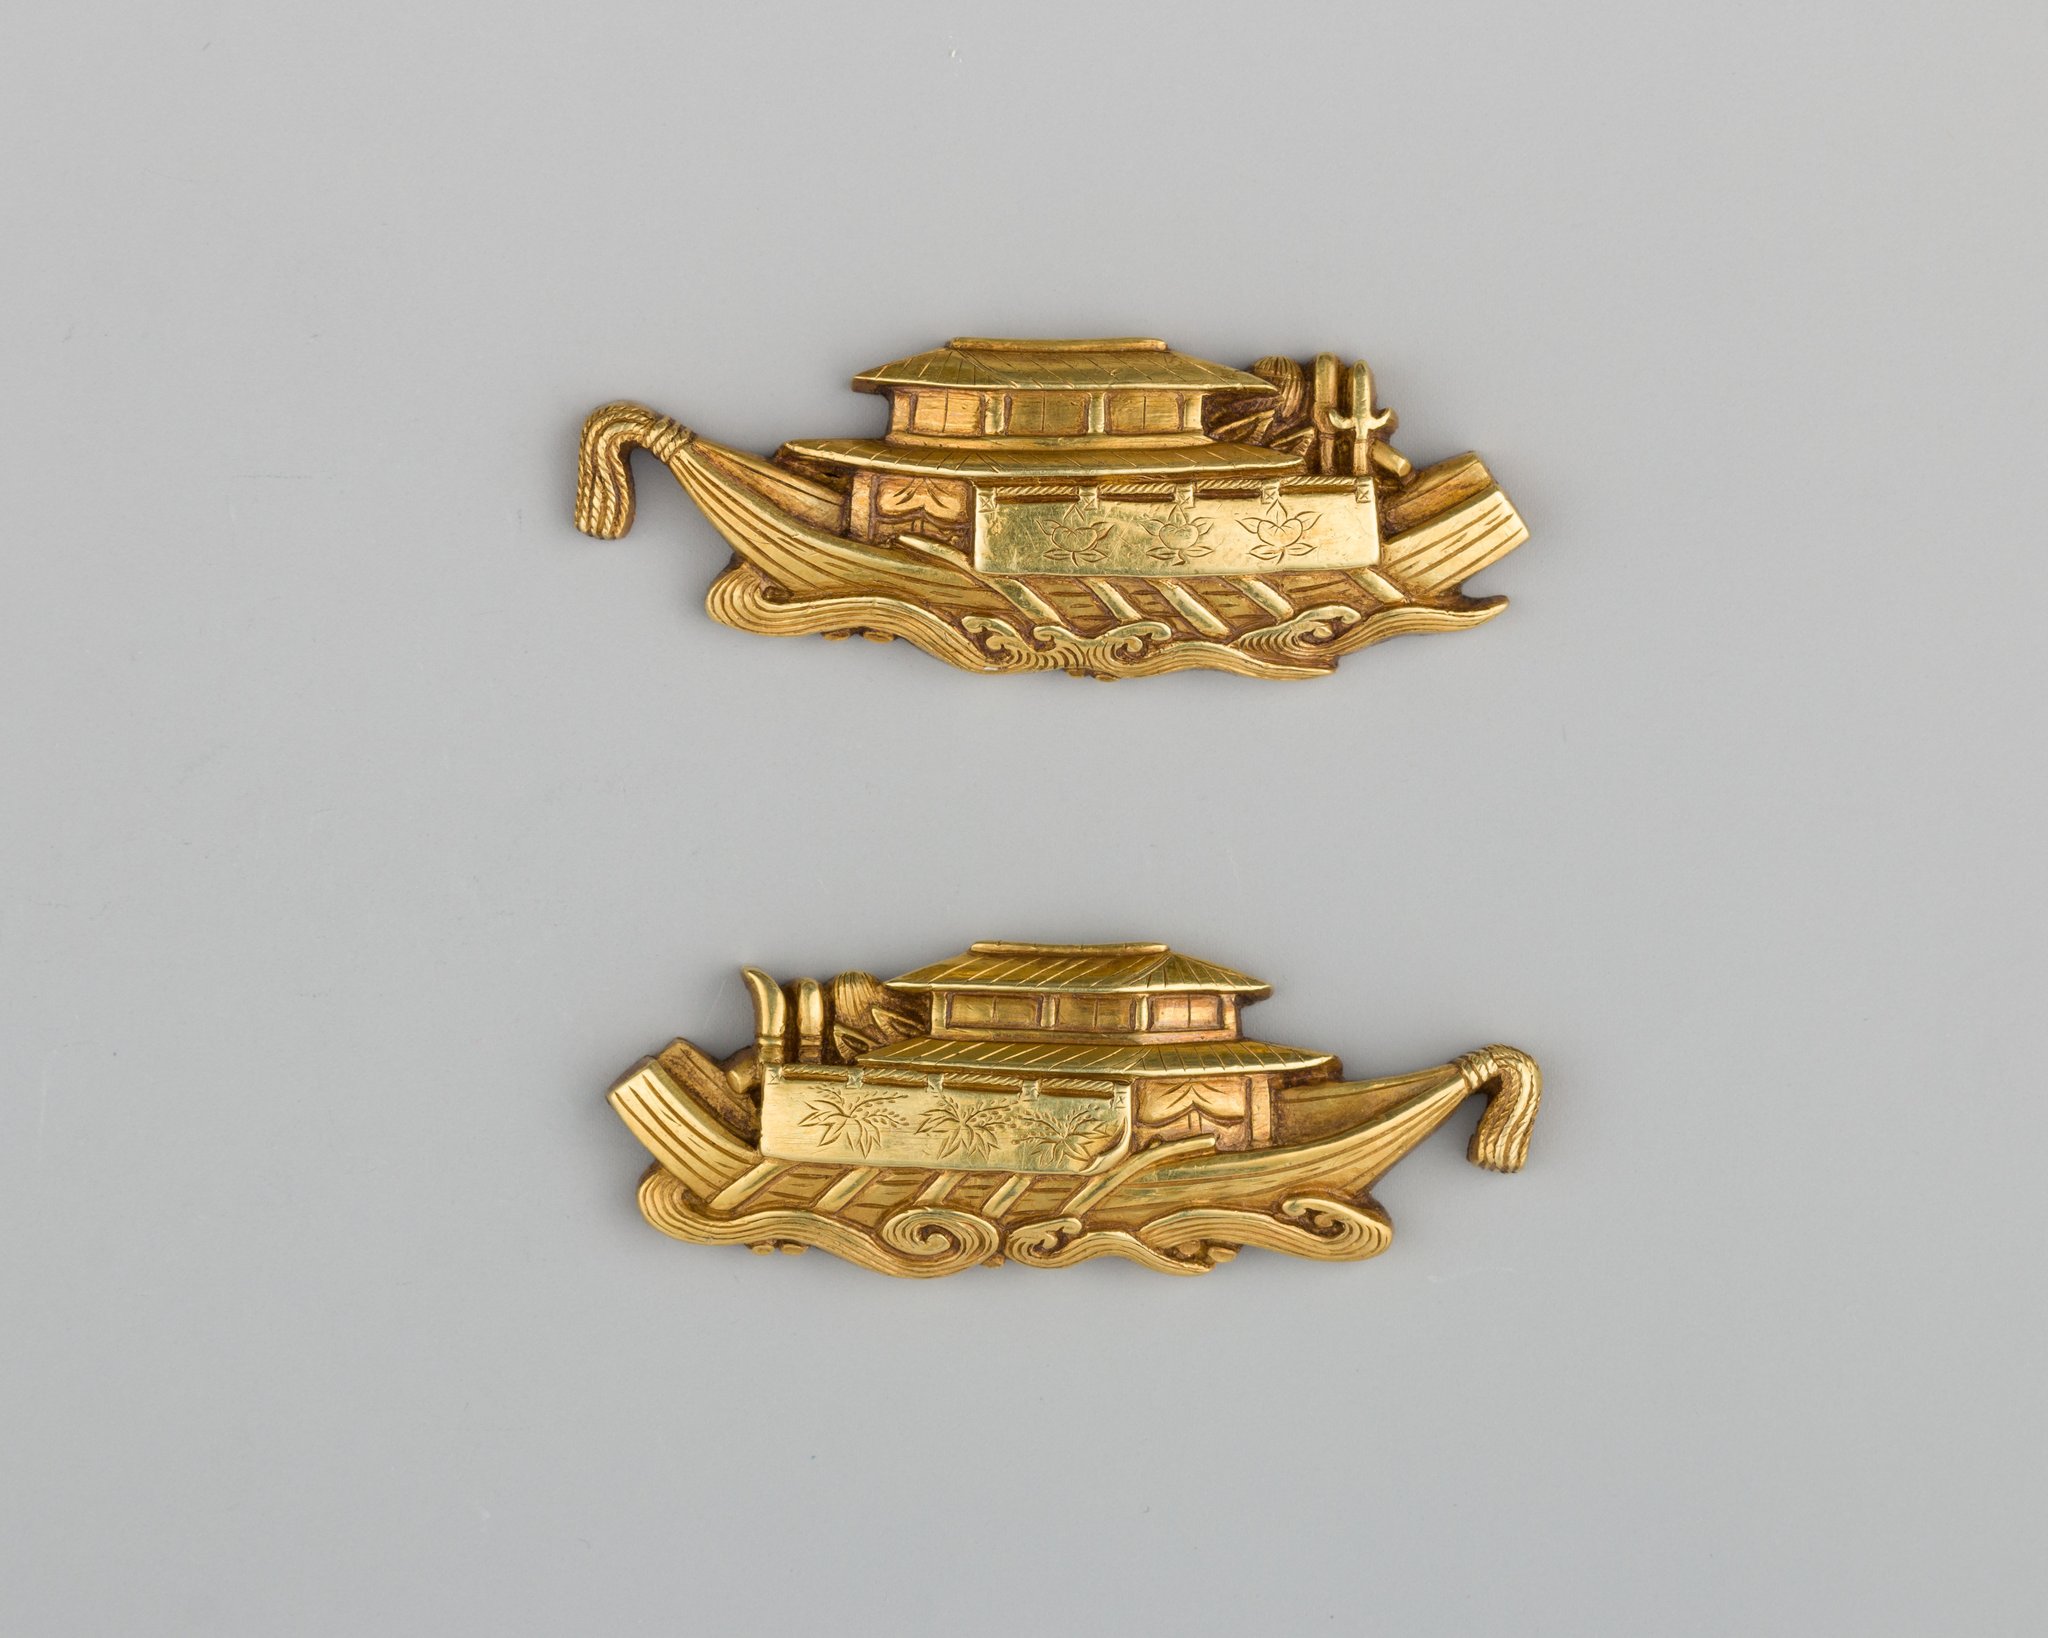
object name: pair of sword grip ornament menuki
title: Pair of Sword-Grip Ornaments (Menuki)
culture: japanese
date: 1701-1800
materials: gold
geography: japan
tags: boats